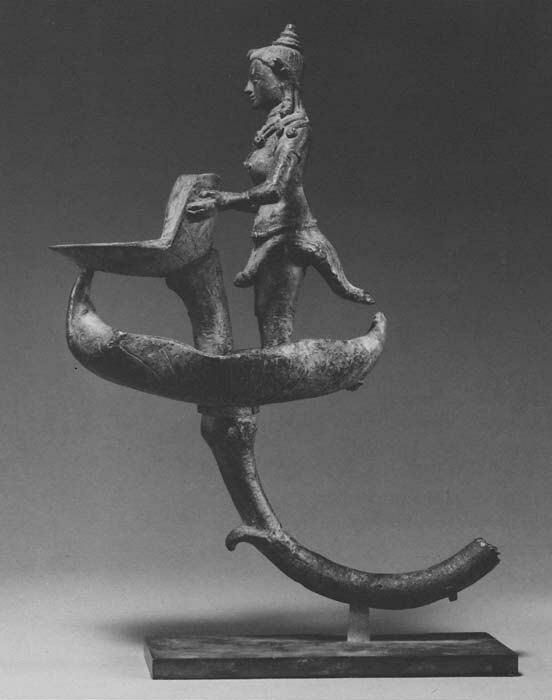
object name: figure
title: Standing Kinnari Holding an Oil Receptacle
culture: indonesian, javanese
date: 901-925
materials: bronze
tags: mythical creatures